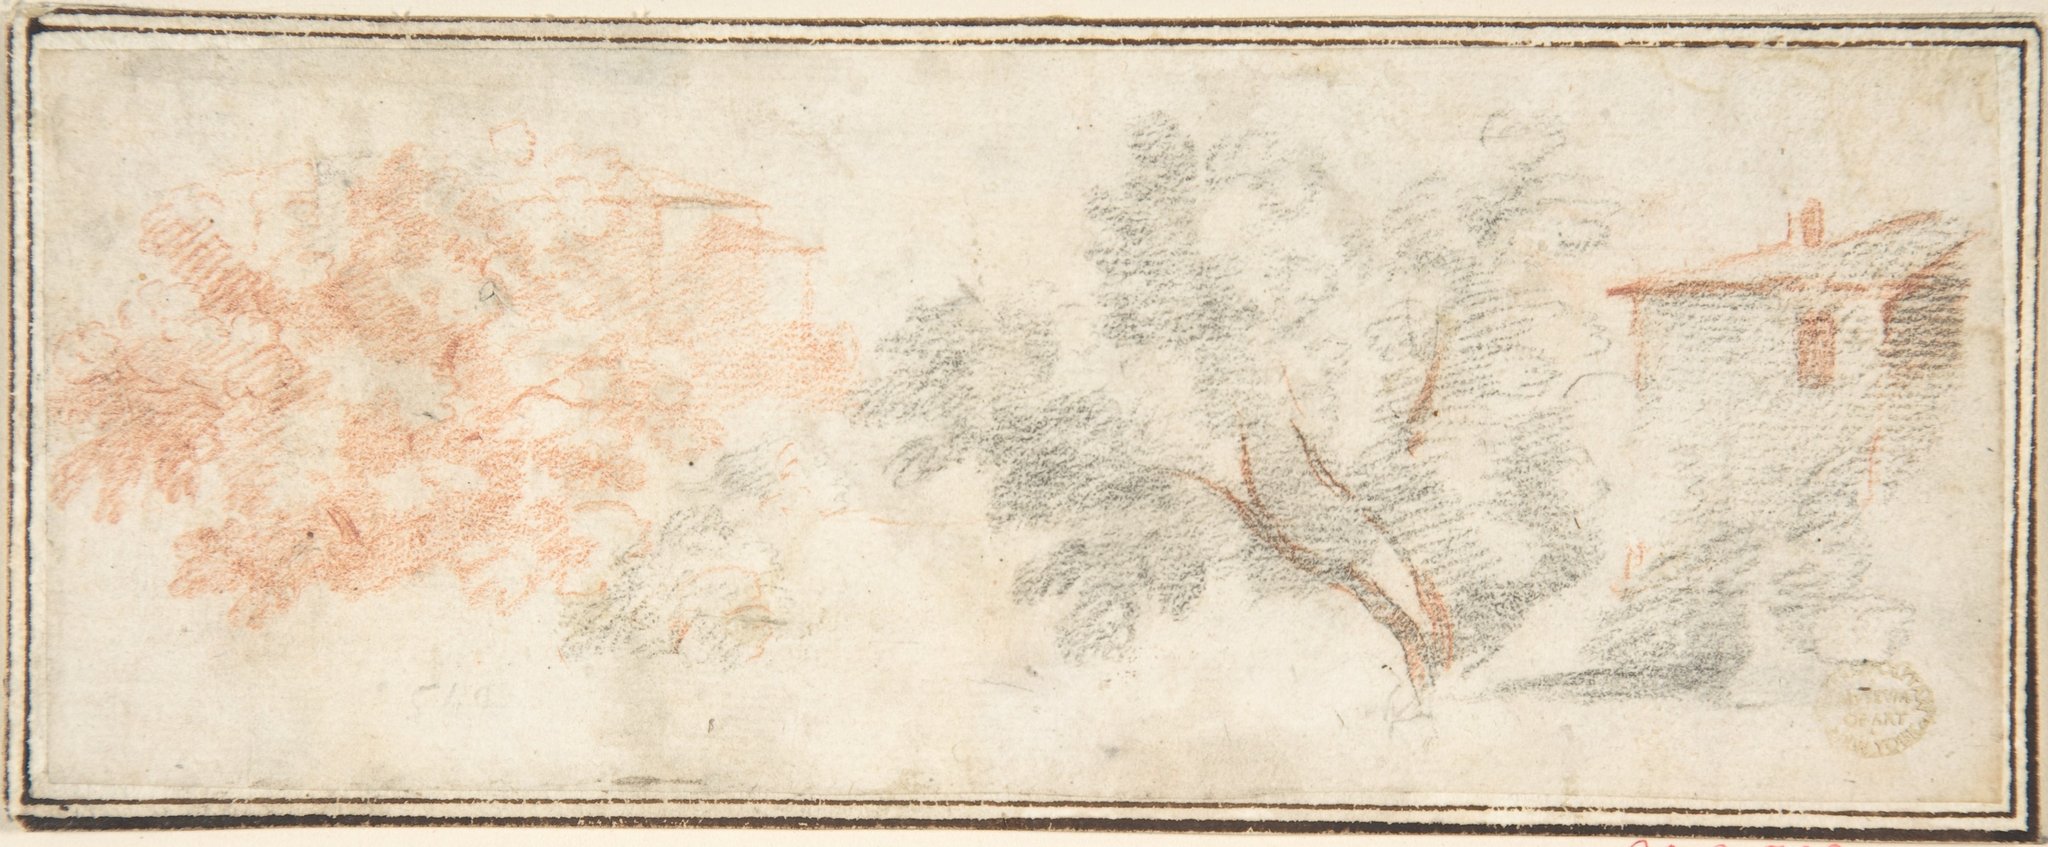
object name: drawing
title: Trees and Houses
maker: anonymous, italian, roman-bolognese, 17th century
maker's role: artist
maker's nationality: italian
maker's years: 1600-1700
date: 1601-1700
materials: chalk, paper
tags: houses,trees